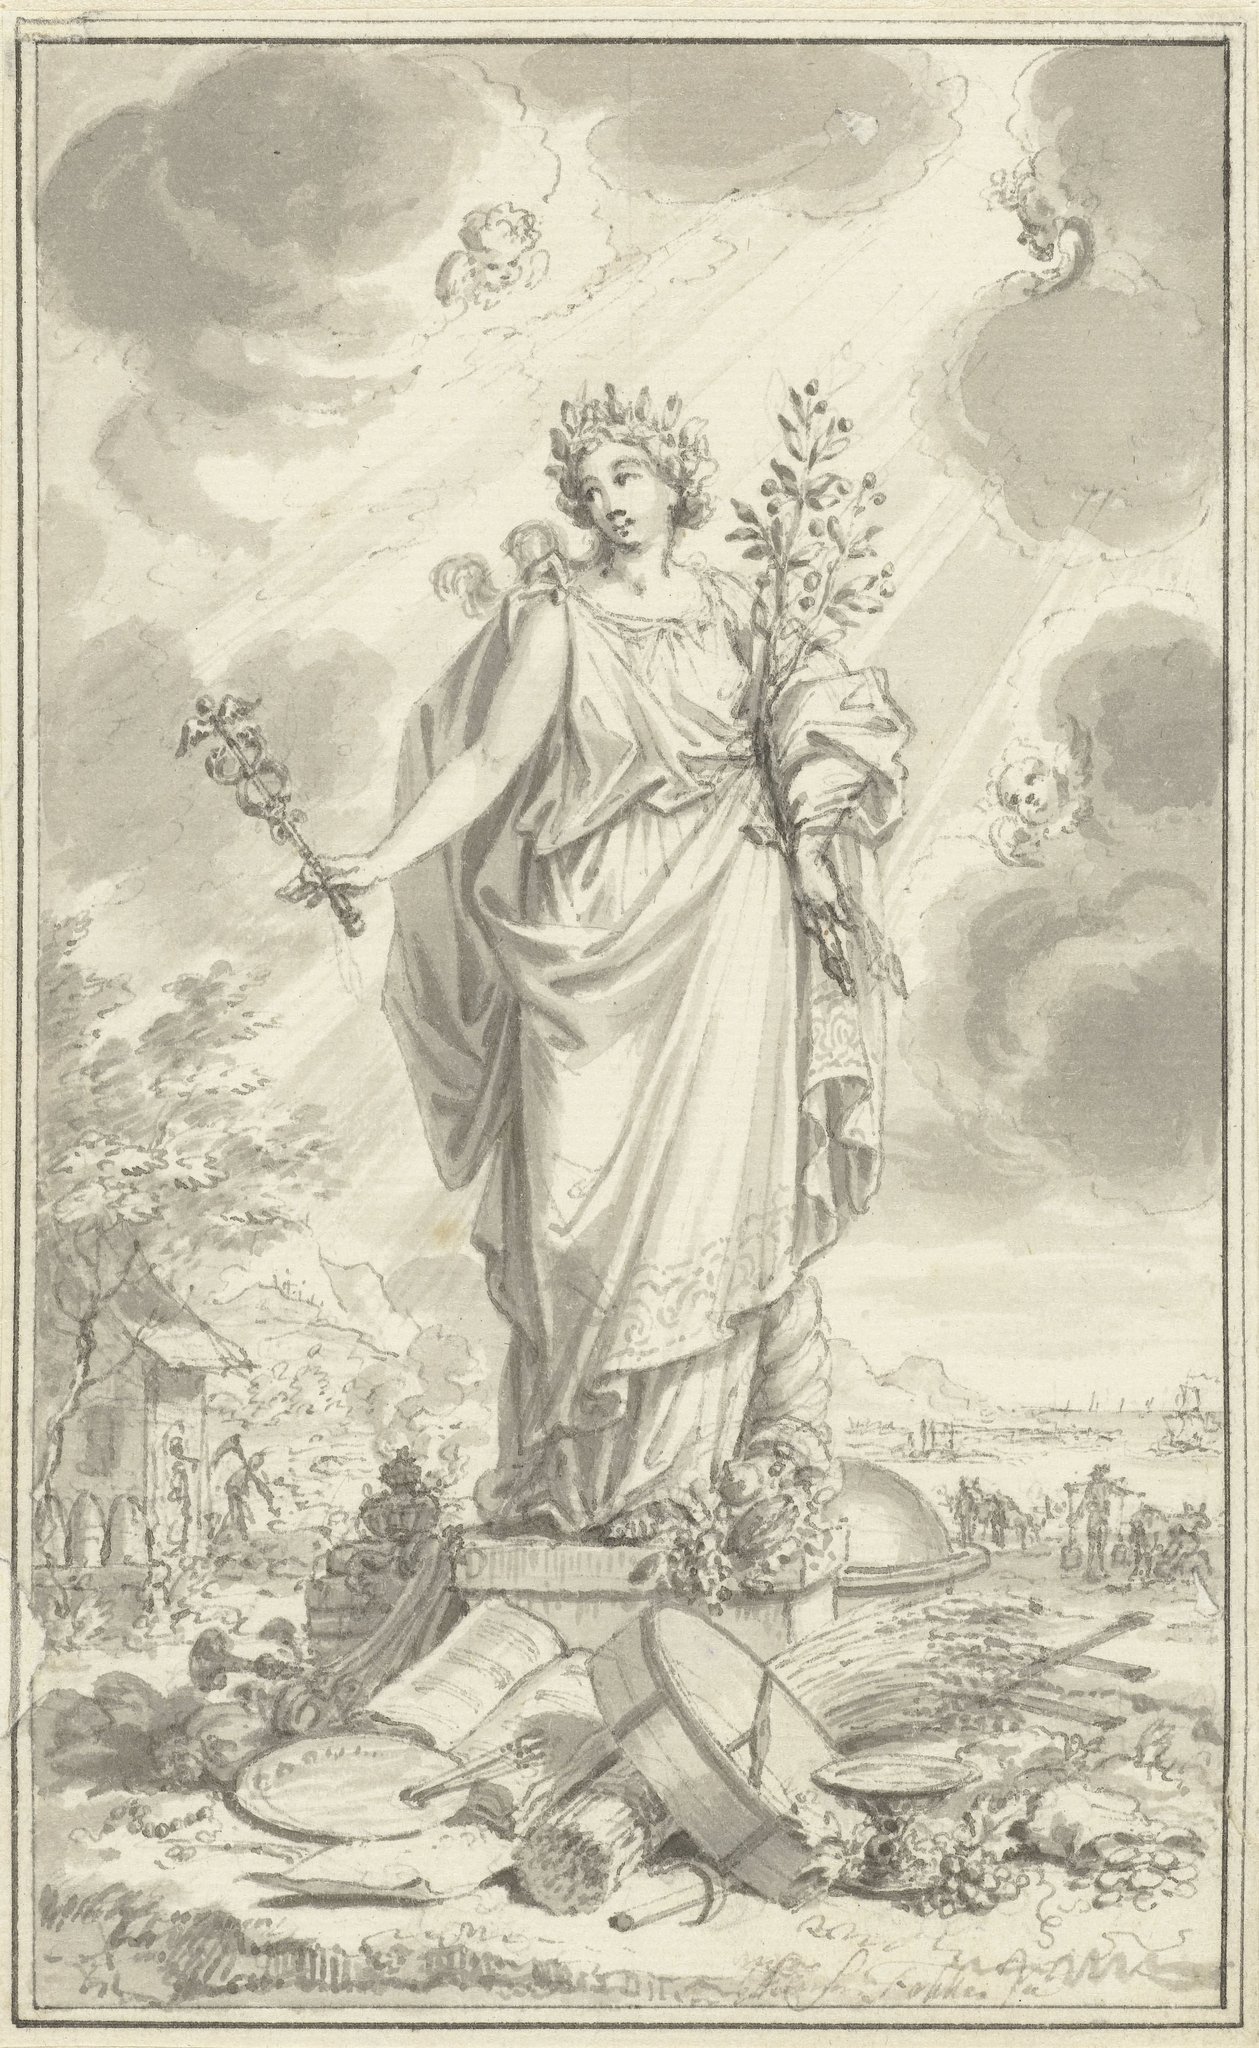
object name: drawing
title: Het standbeeld van de Vrede, 1748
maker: simon fokke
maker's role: draughtsman, print maker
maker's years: 1712-1784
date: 1748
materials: paper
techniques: pouncing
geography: northern netherlands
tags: symbols, allegories of peace, 'pax'; 'pace' (ripa), proclamation of peace, piece of sculpture, reproduction of a piece of sculpture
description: Standbeeld van de vrouwelijke personificatie van de Vrede (Pax), hier specifieker verwijzend naar de Vrede van Aken gesloten op 18 oktober 1748 tussen de Geallieerden (Republiek, Engeland en Oostenrijk) enerzijds en Frankrijk, Pruisen en Spanje anderzijds. In de wolken engelenkopjes. Aan de voeten van het beeld objecten die verwijzen naar de bloei van de economie, landbouw, kunsten en wetenschappen in vredestijd. Ontwerp voor een prent.